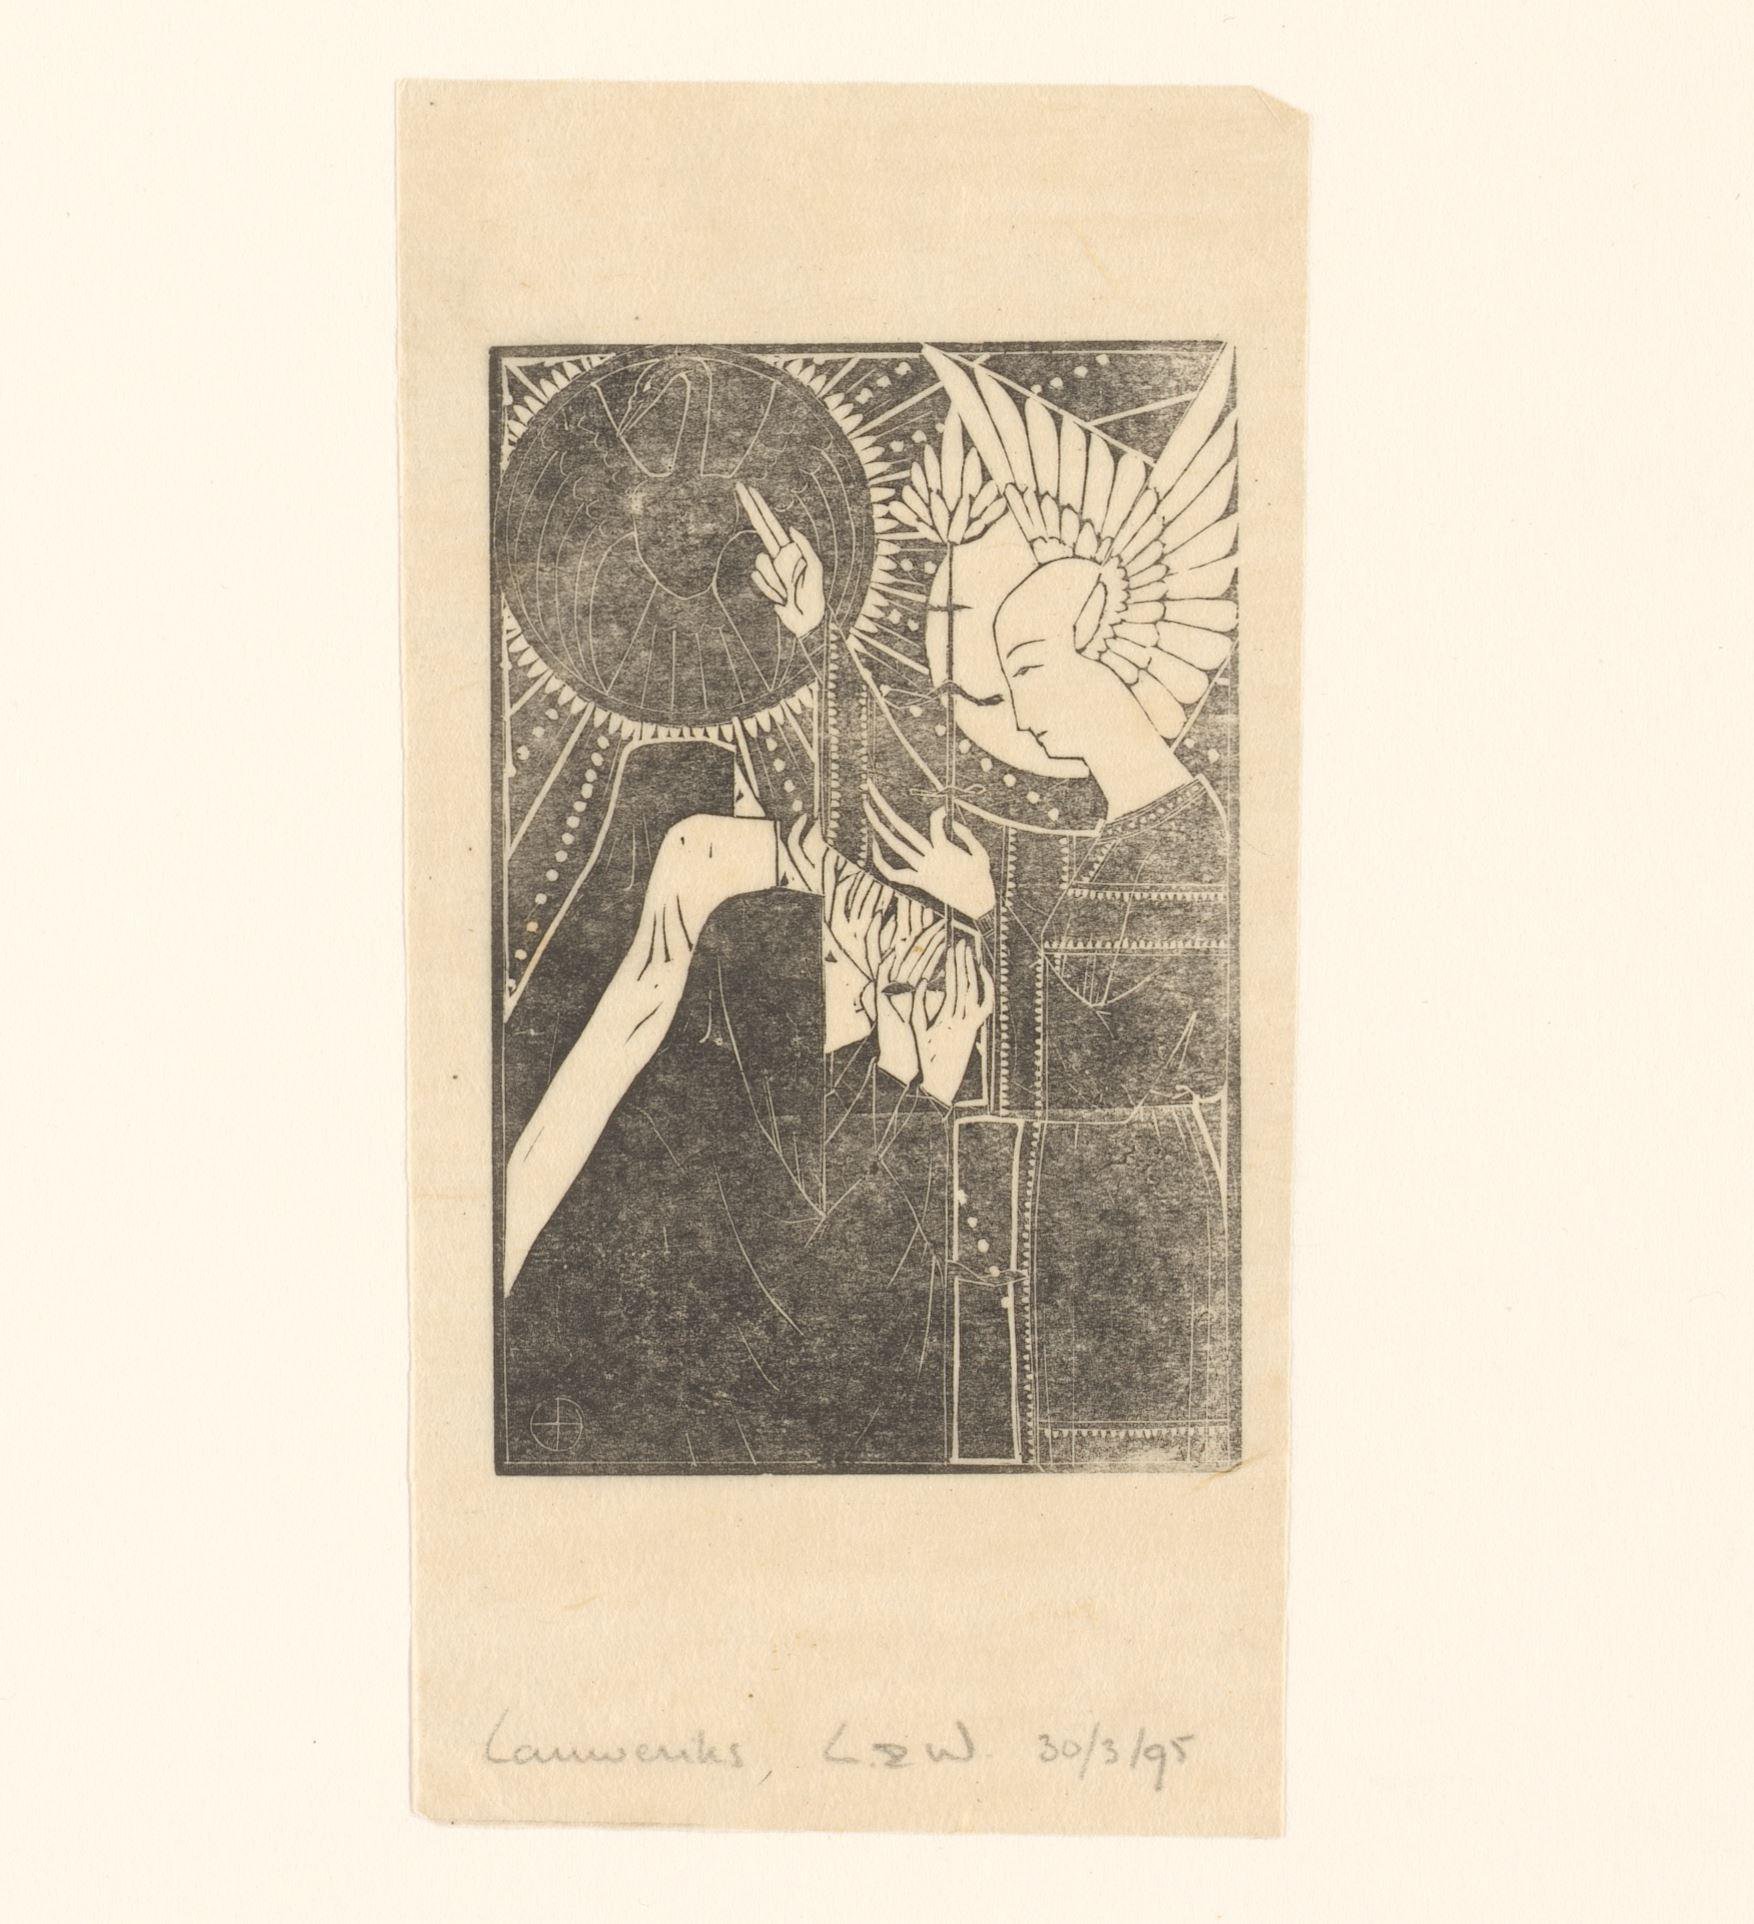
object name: print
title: De verloste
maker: mathieu lauweriks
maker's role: designer, draughtsman, print maker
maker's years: 1864-1932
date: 1895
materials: paper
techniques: woodcut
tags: kneeling figure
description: Rechts staat een man met vleugels in plaats van oren. Hij wendt zich tot de drie figuren die voor hem knielen. In zijn linkerhand houdt hij een bloem; met rechts wijst hij naar de zon waarin een vogel met gespreide vleugels te zien is.